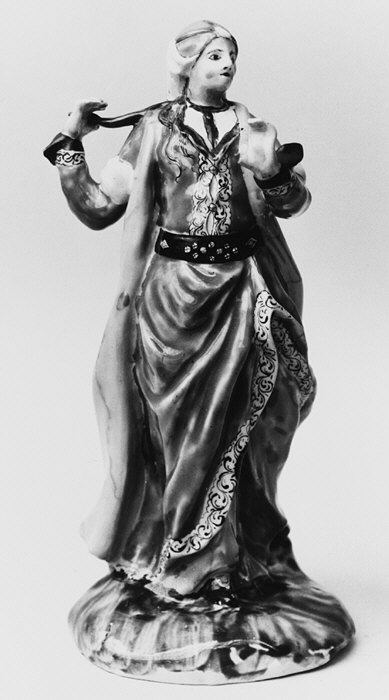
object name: figure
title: Turkish woman (one of a pair)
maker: meissen manufactory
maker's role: manufactory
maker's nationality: german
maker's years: 1710-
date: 1760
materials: enamel, stoneware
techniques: painting, salt glaze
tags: portraits,women